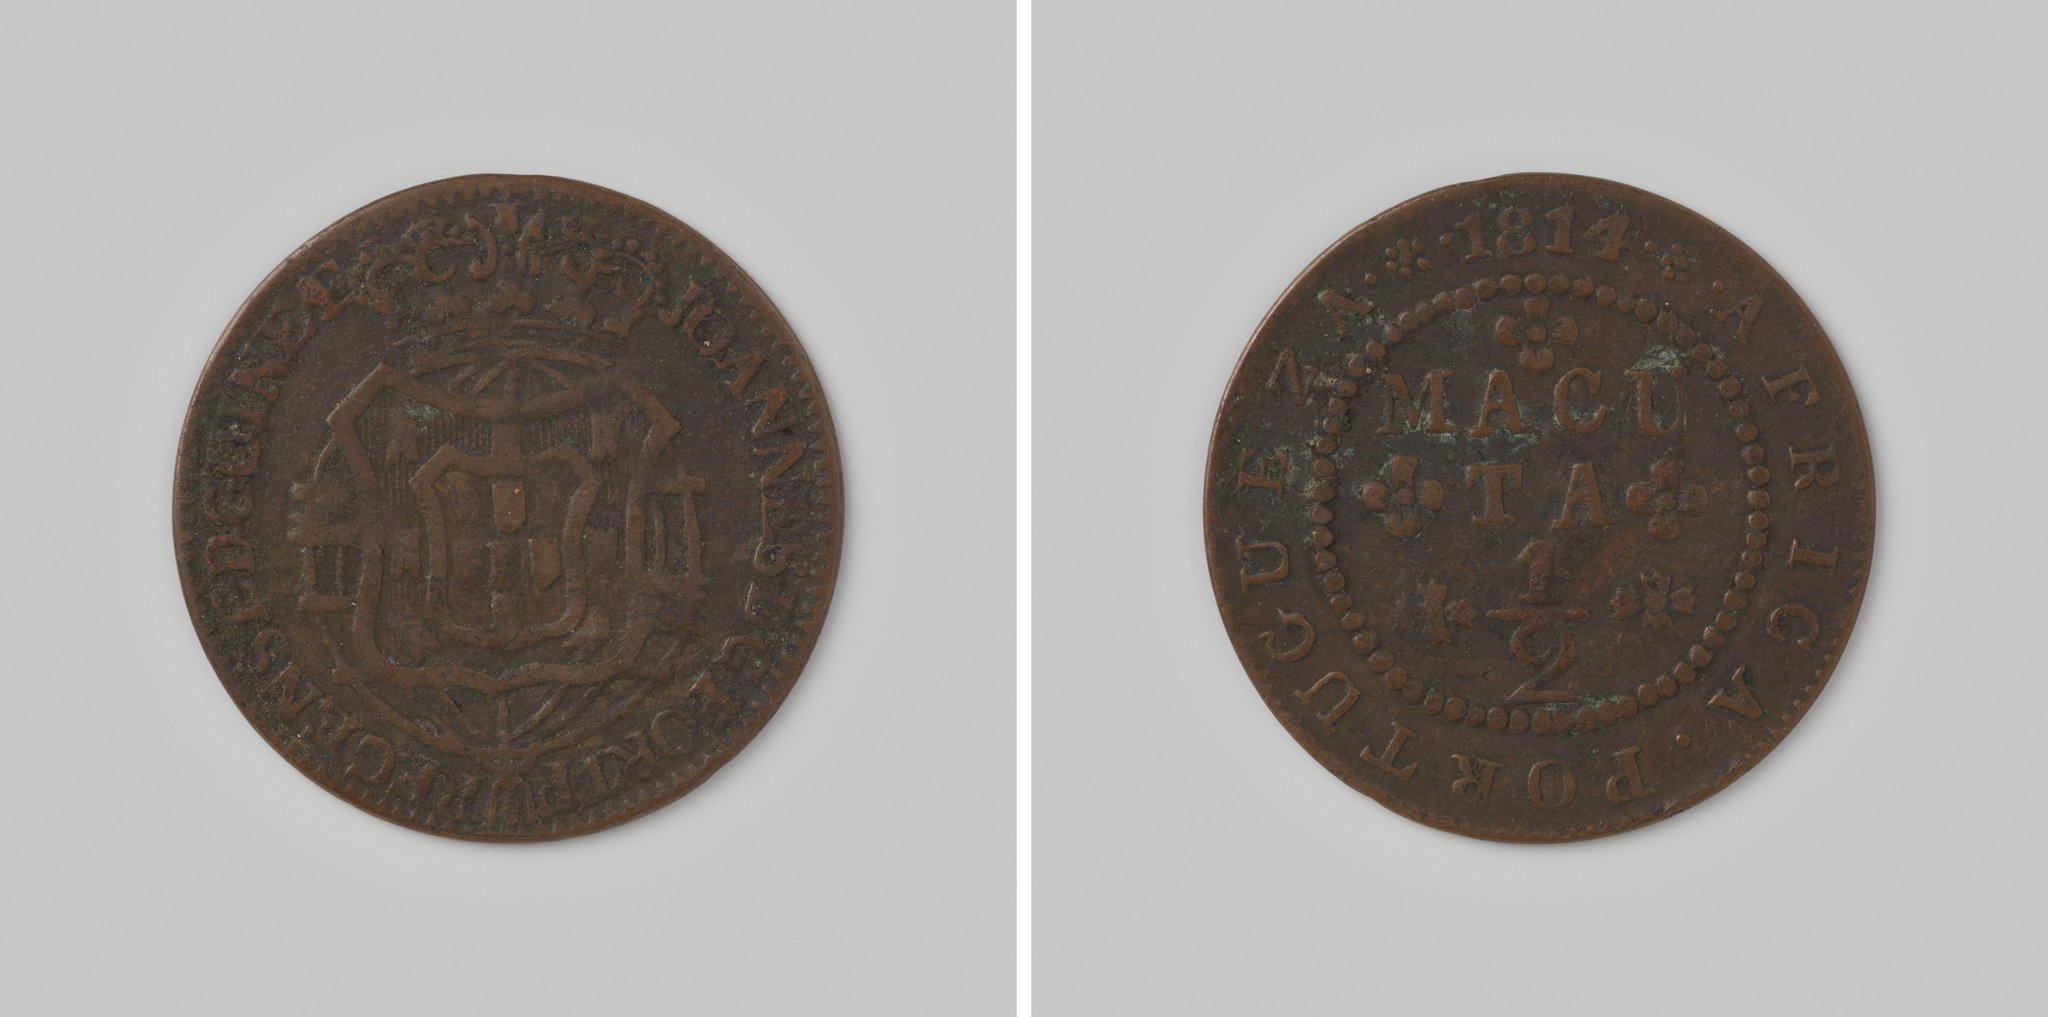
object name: coin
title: ½ macuta uit Angola van de Portugese koning Joao VI, 1814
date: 1814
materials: copper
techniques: striking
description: Koperen munt. Voorzijde: op omwikkelde wereldbol gekroond wapenschild van Portugal. Keerzijde: binnen parelcirikel in drie regels waarde-aanduiding: macuta ½.. Omschrift: Africa Portugueza met jaartal bovenaan. Gladde rand.